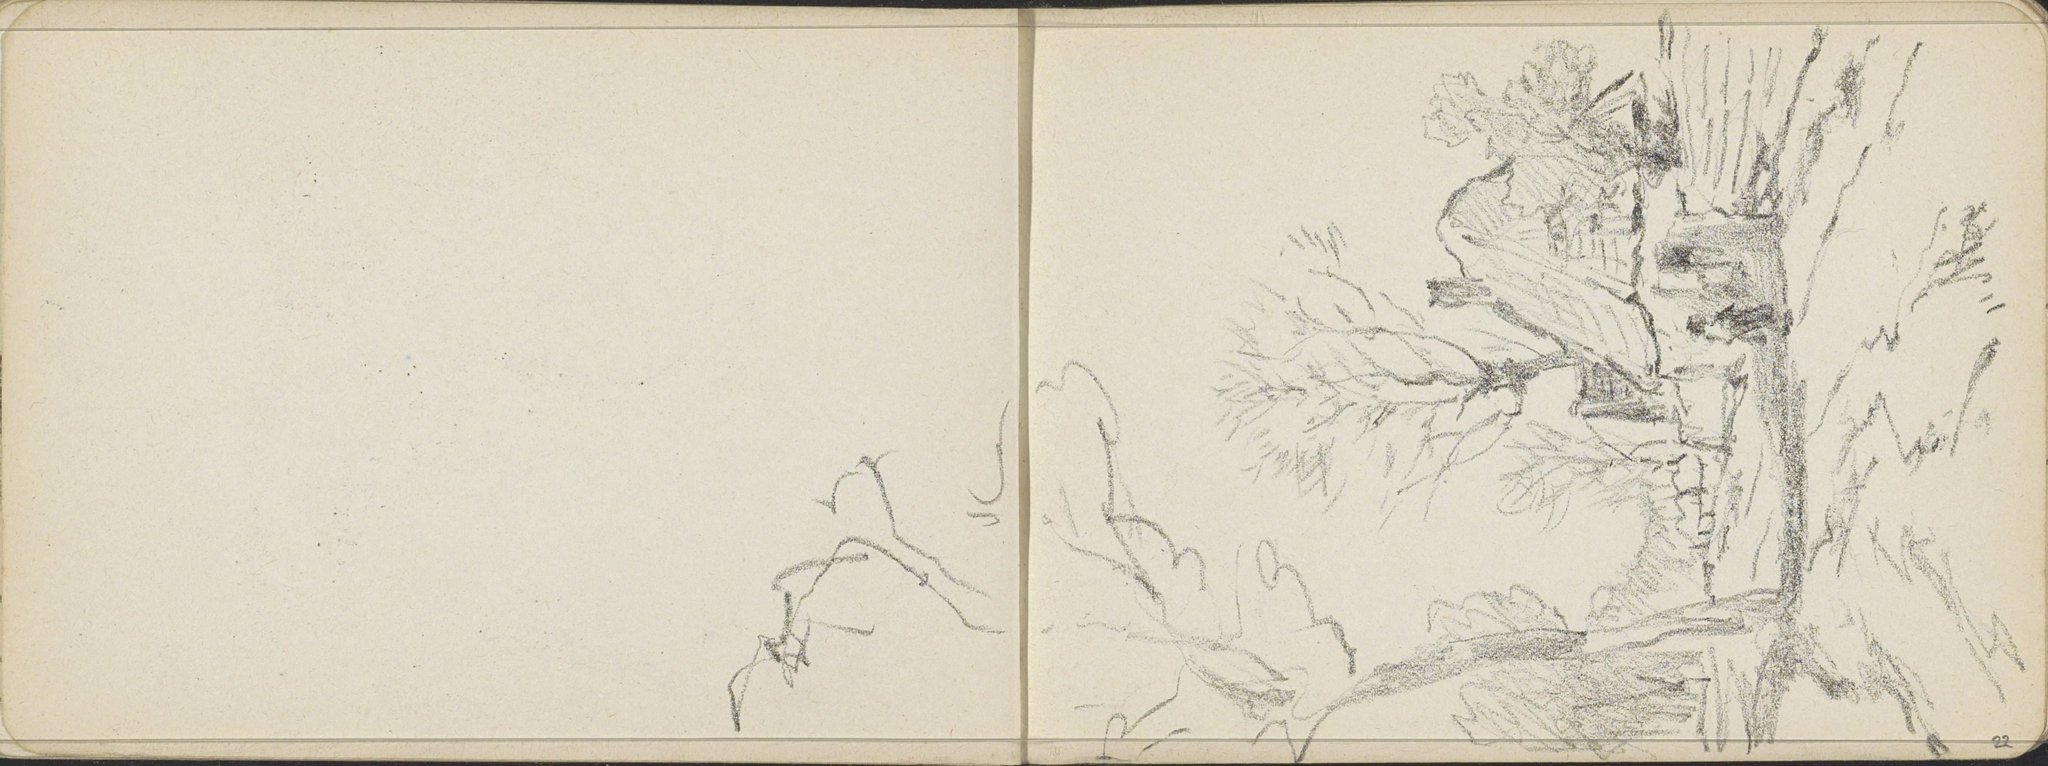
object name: sketchbook leaf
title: Arbeiderswoningen aan een landweg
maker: willem cornelis rip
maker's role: draughtsman, painter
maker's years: 1856-1922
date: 1905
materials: chalk, paper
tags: road, path, cottage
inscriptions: date: ‘11 Mei’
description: Blad 21 verso en 22 recto uit een schetsboek met 42 bladen.